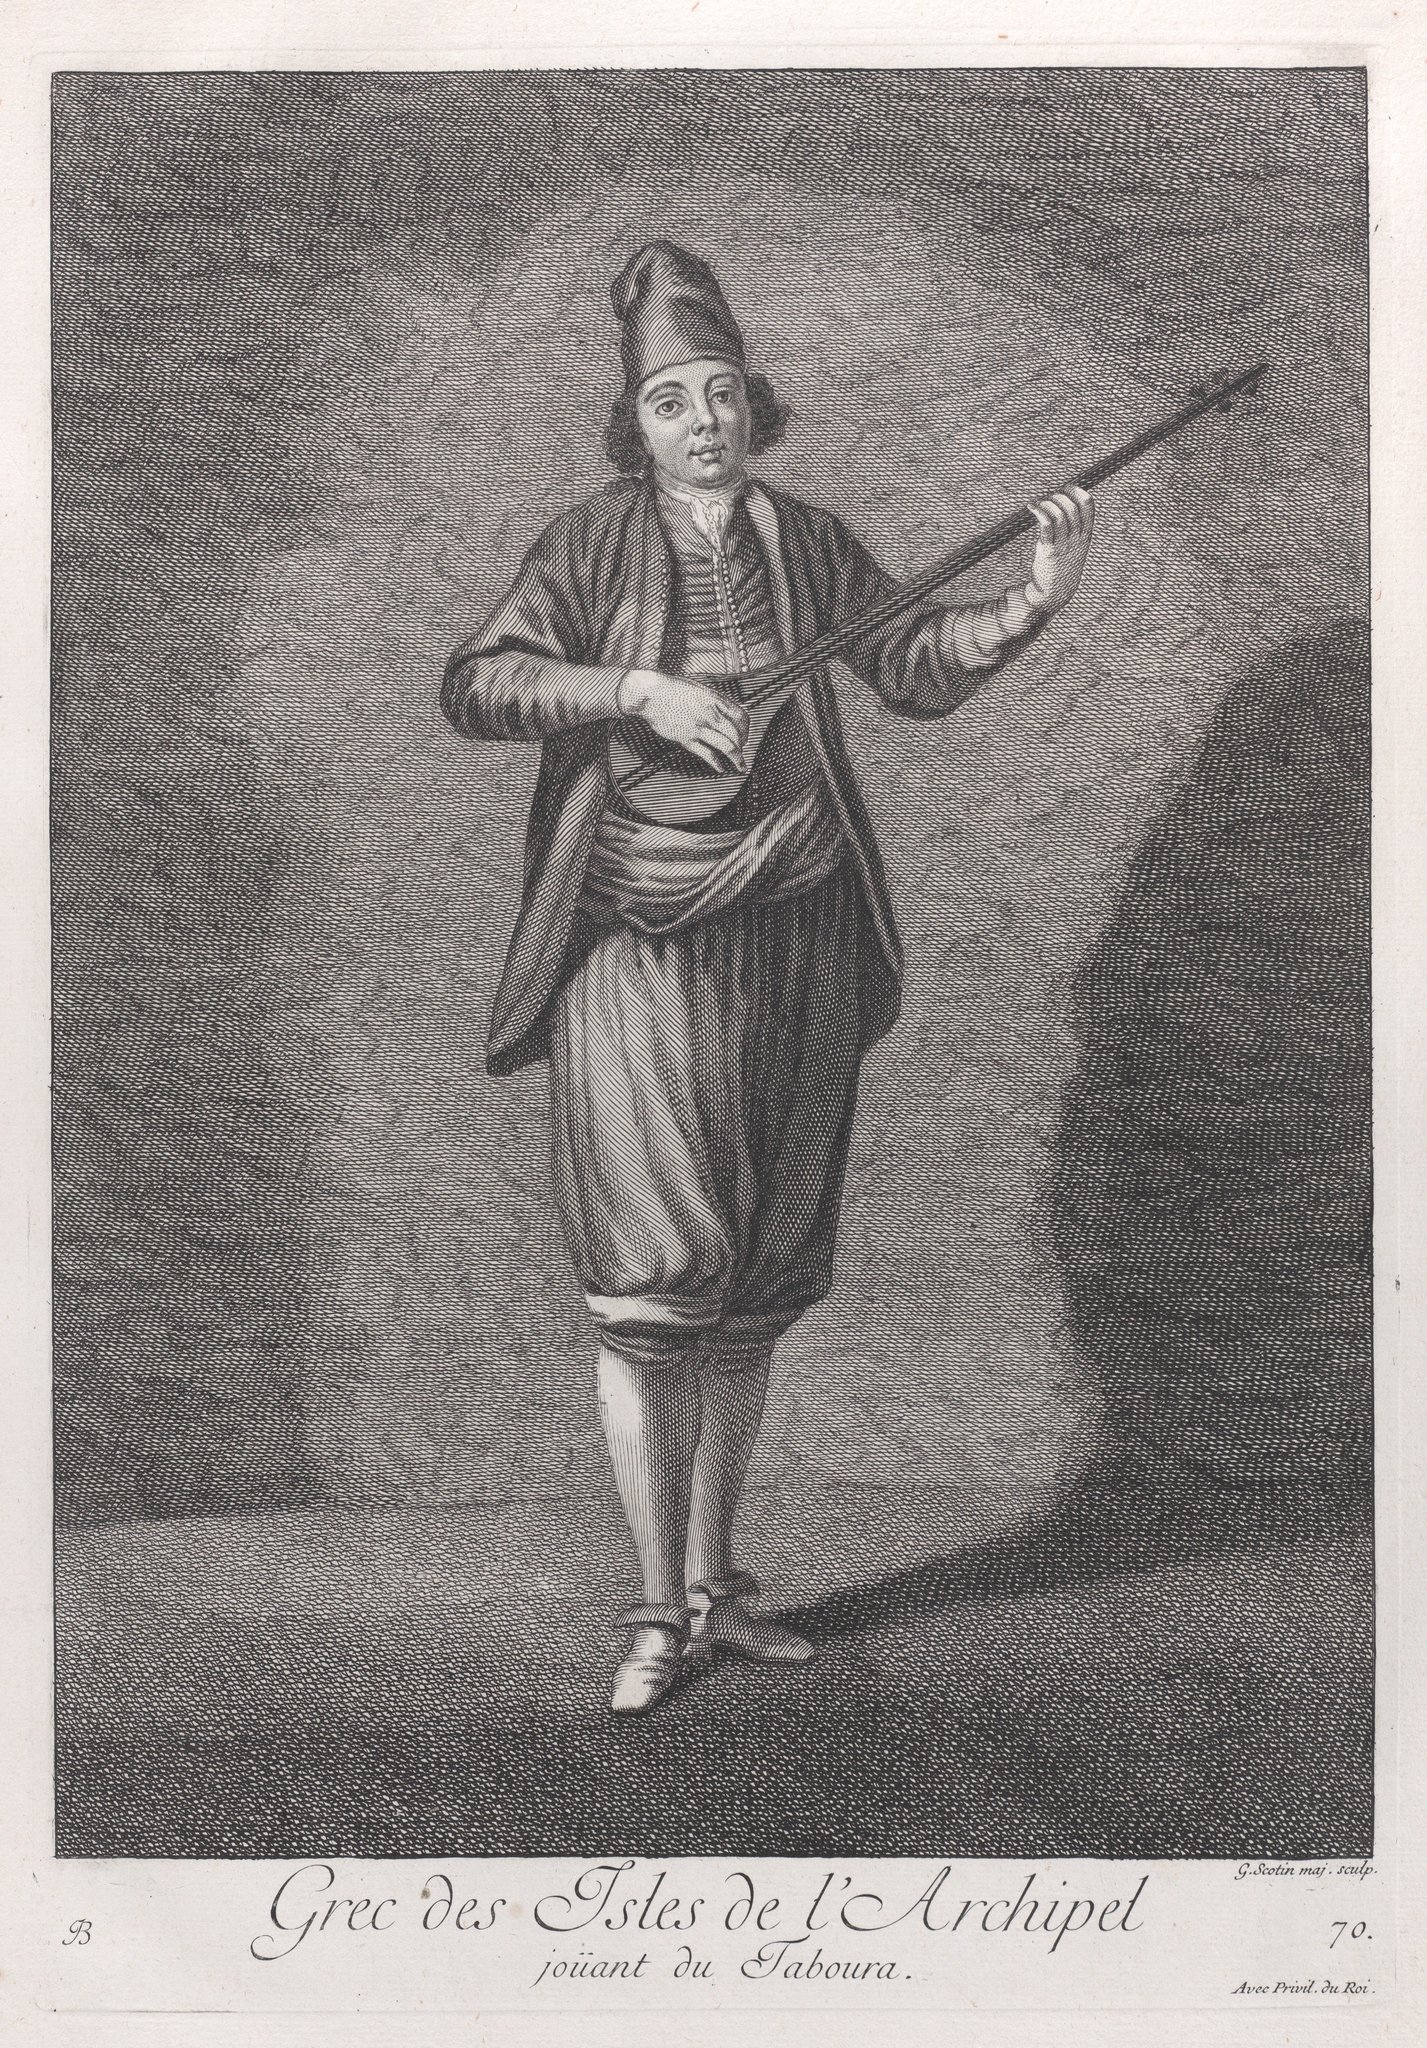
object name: print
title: Grec des Isles de l'Archipel, joüant du Taboura, plate 70 from "Recueil de cent estampes représentent differentes nations du Levant"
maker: jean baptiste vanmour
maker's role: artist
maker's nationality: french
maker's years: 1671-1737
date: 1714-1715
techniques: engraving, etching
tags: musical instruments,men